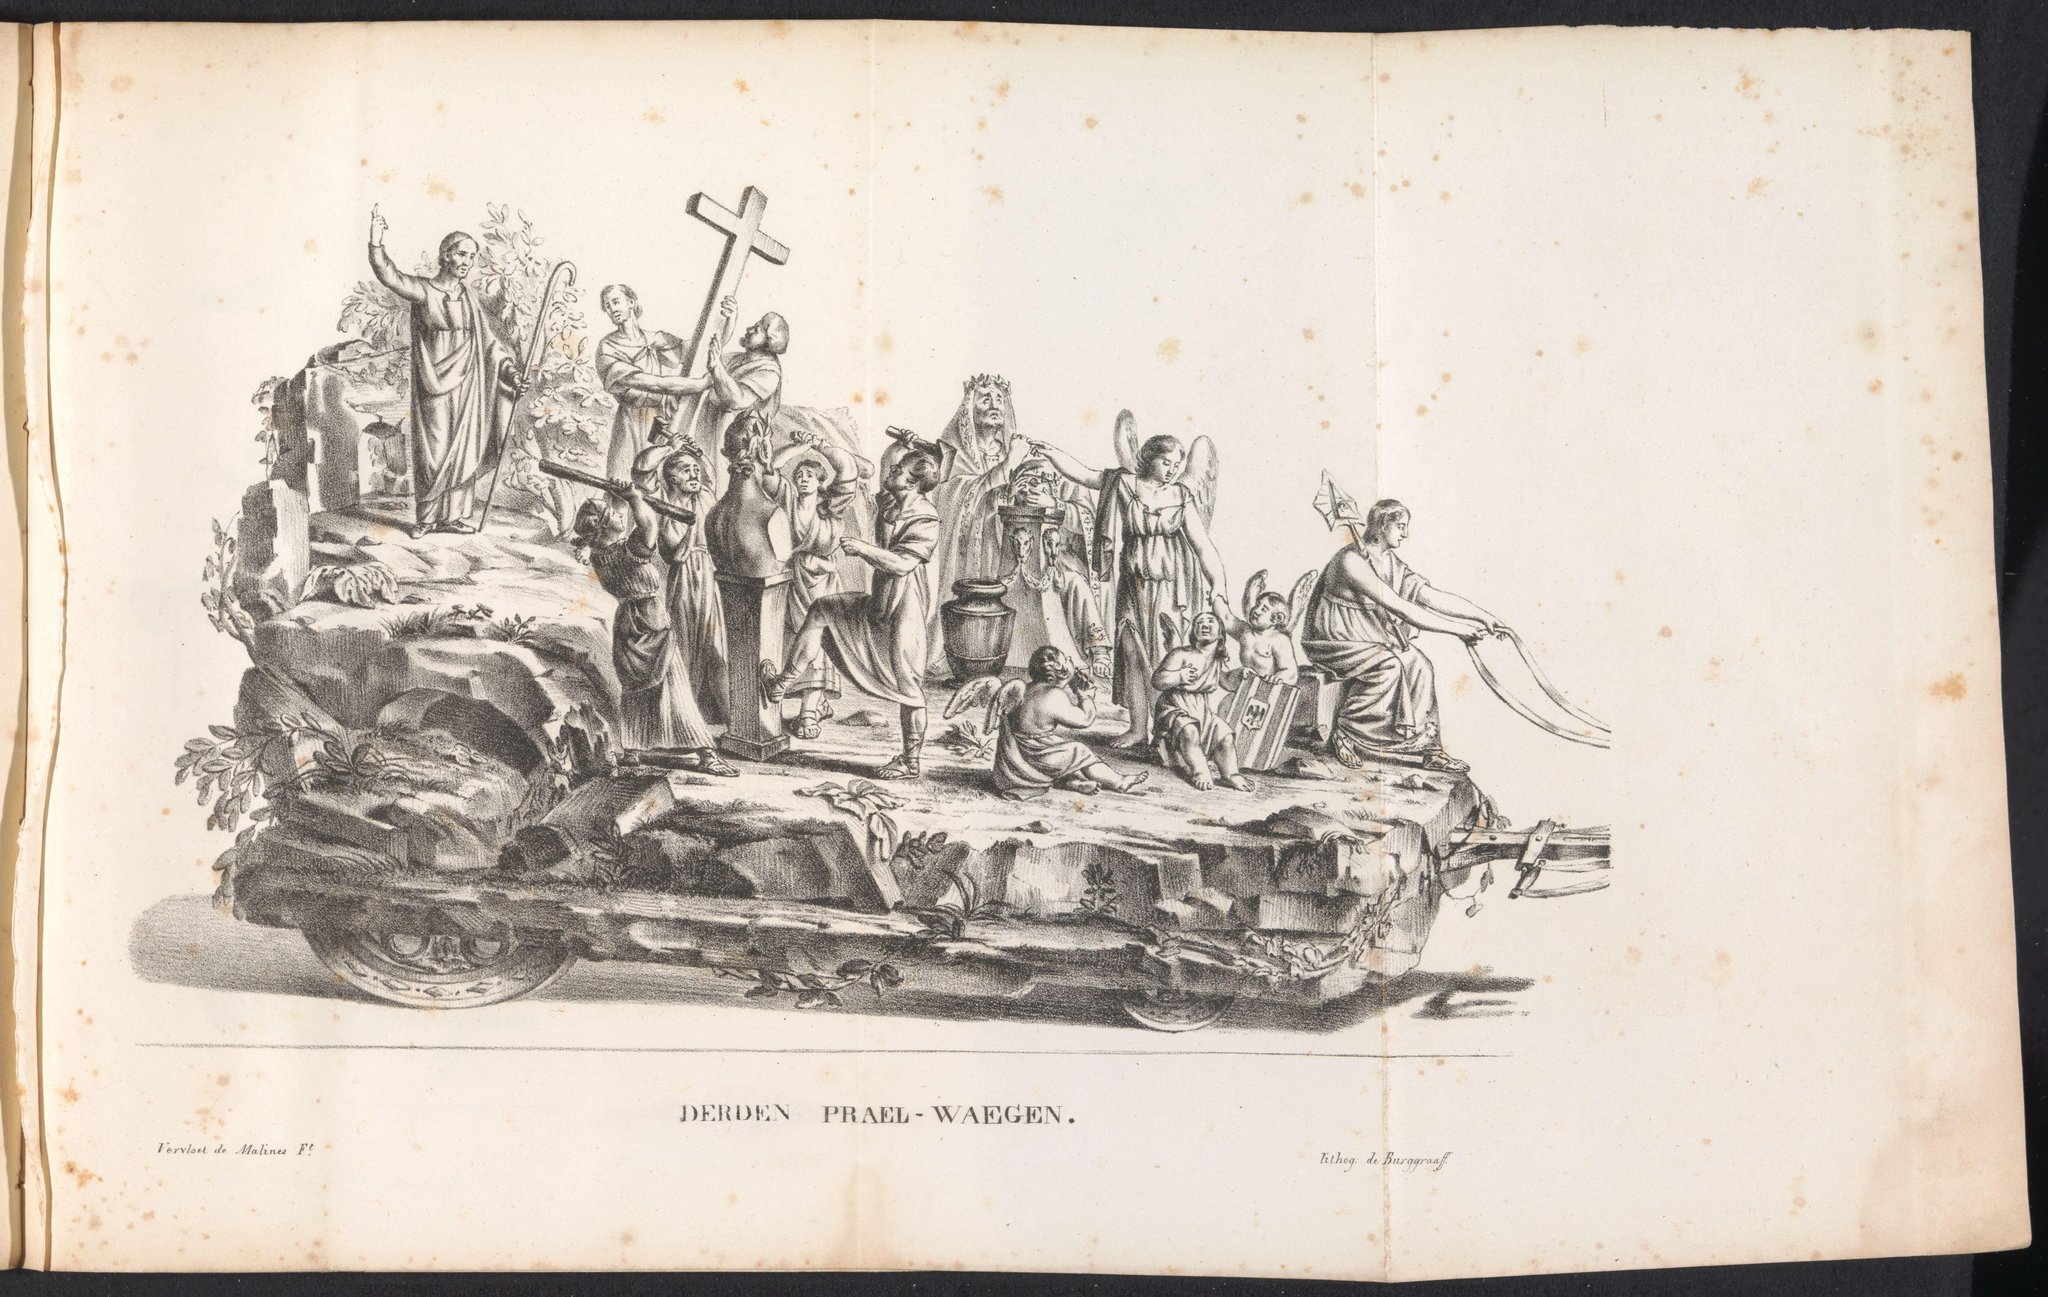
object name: print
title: Derden Prael-waegen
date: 1825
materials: paper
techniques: lithograph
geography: mechelen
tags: destruction of pagan idols, rejoicing on special occasions (+ parade, pageant, cavalcade ~ festive activities), non-miraculous activities and events ~ st. rumbold, procession ~ christian religion, mechelen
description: De derde praalwagen in de ommegang voor de Heilige Rombout. Op de wagen de prediking van Rombout en de vernietiging van afgodsbeelden in Mechelen. De optocht werd gehouden op 28 juni, 5 en 12 juli 1825. Illustratie in een publicatie ter gelegenheid van de 1050-jarige viering in 1825 van de dood van de Heilige Rumoldus of Rombout, patroonheilige van de stad Mechelen, van wie werd gedcaht dat hij in 775 was overleden.